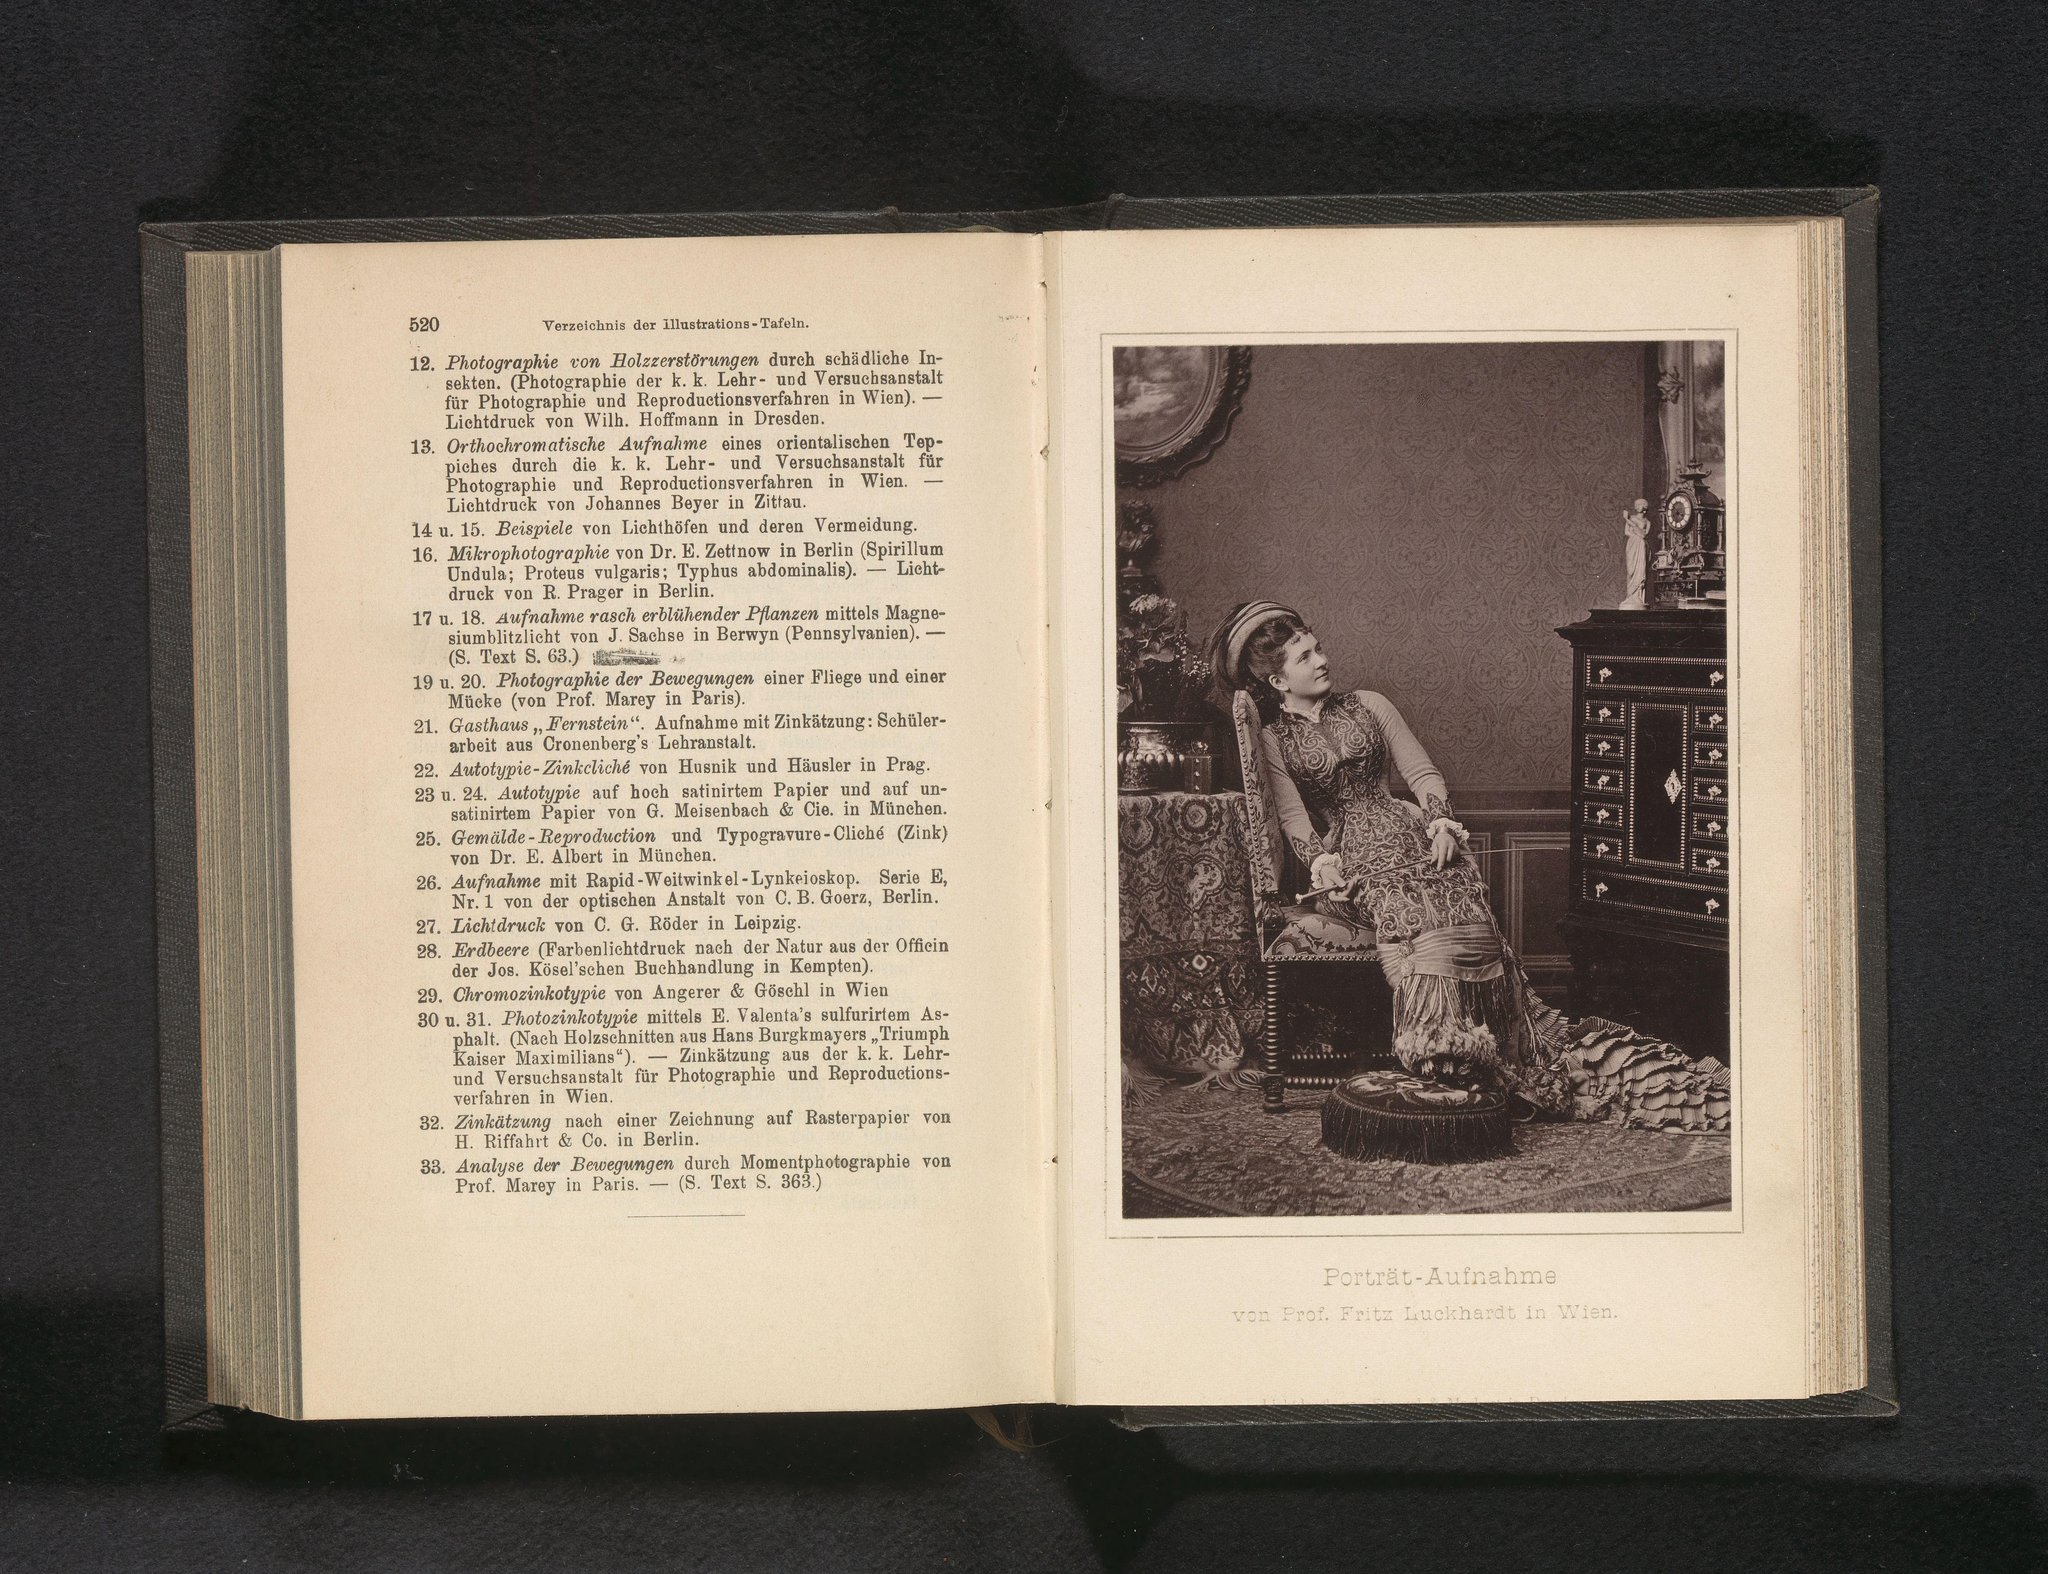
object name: photomechanical print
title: Portret van een gezeten onbekende vrouw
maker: fritz luckhardt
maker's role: fotograaf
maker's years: 1843-1894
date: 1887-1892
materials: paper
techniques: photograph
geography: dresden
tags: historical persons - bb - woman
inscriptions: inscription: ‘Porträt-Aufnahme’